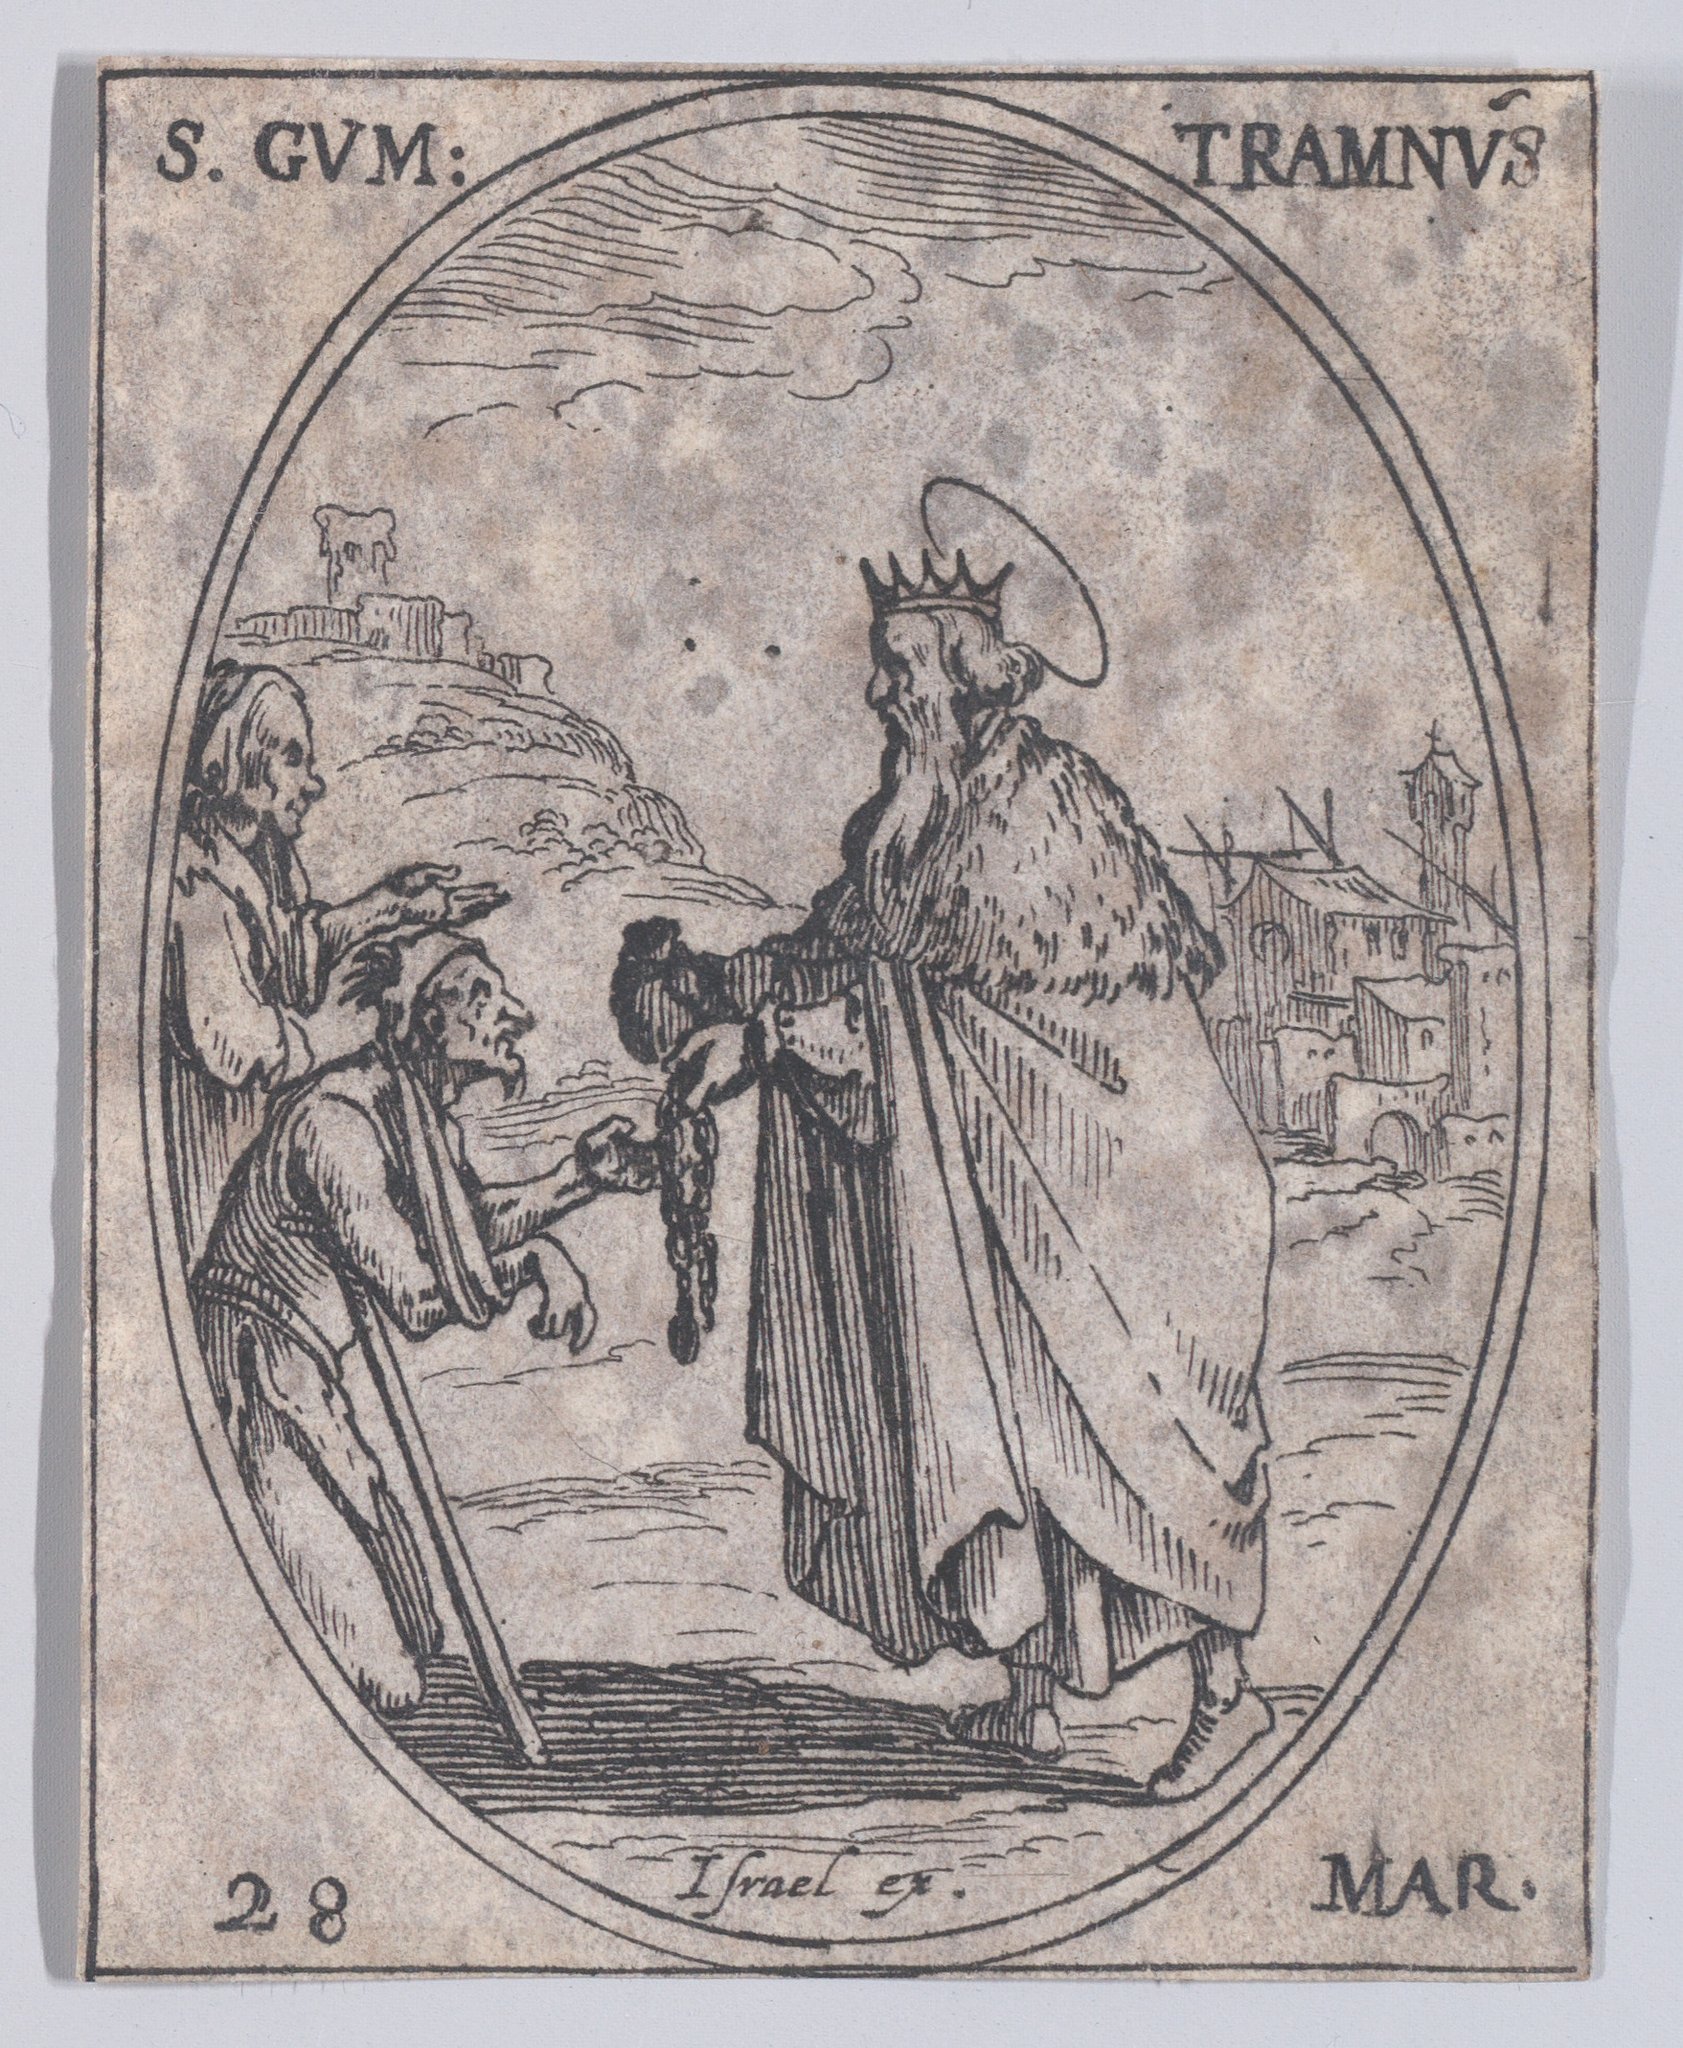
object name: print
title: S. Gontran (St. Guntram), March 28th, from "Les Images De Tous Les Saincts et Saintes de L'Année" (Images of All of the Saints and Religious Events of the Year)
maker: jacques callot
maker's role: artist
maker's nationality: french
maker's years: 1592-1635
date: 1636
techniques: etching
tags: men,saints